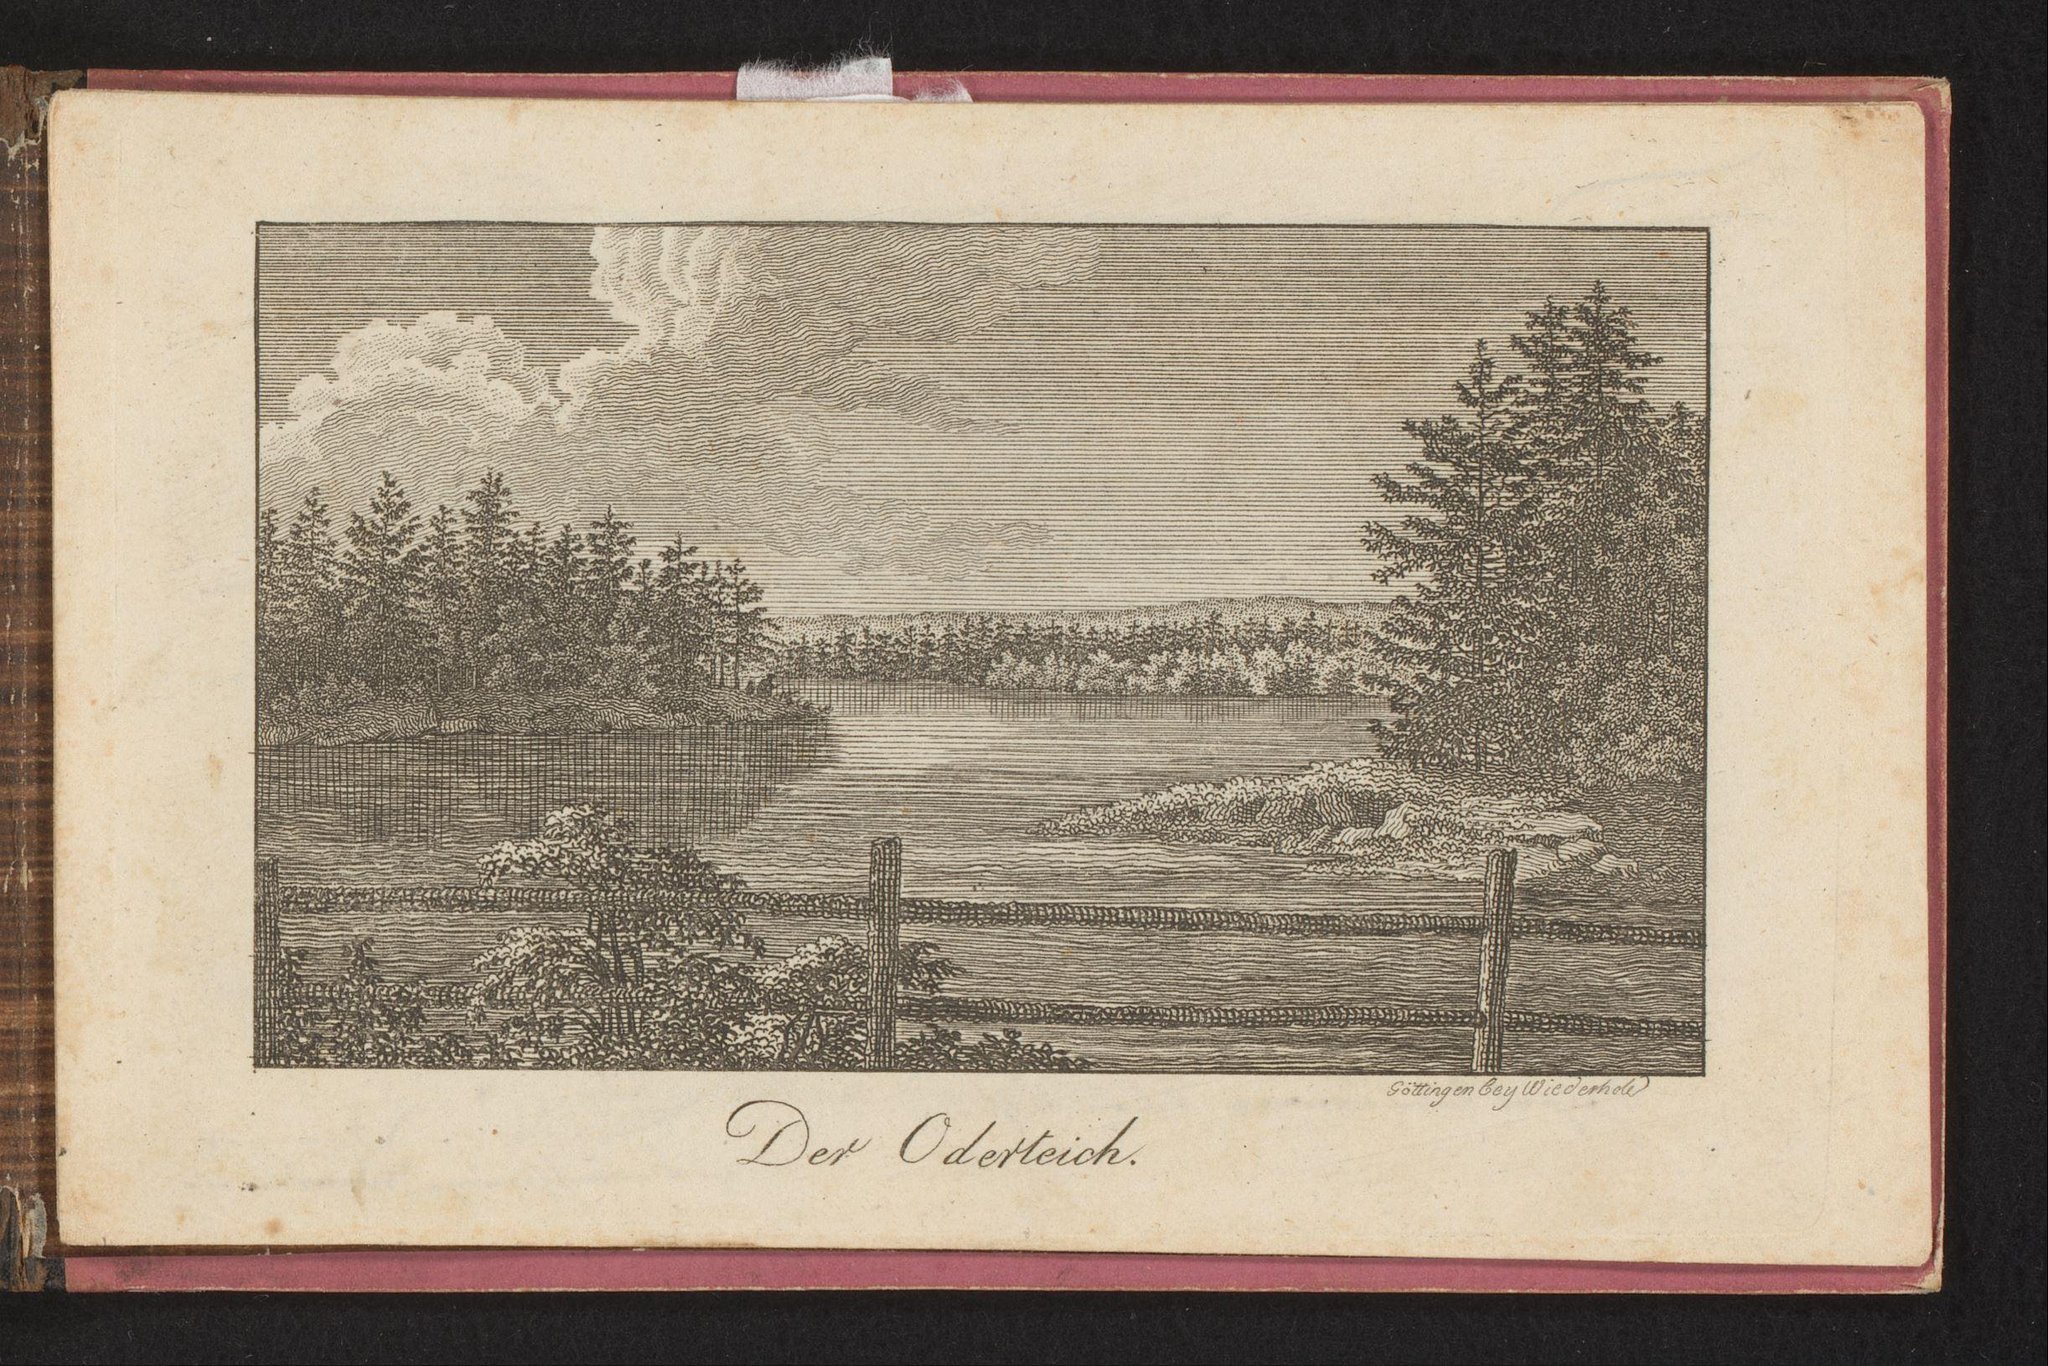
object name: print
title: Der Oderteich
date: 1770-1826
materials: ink, paper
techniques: etching, writing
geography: gottingen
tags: 'album amicorum', 'stammbuch', wildlife reserve, national park, dammed-up lake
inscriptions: tekst, verso, handgeschreven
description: Handgeschreven tekst in het Duits op het verso.